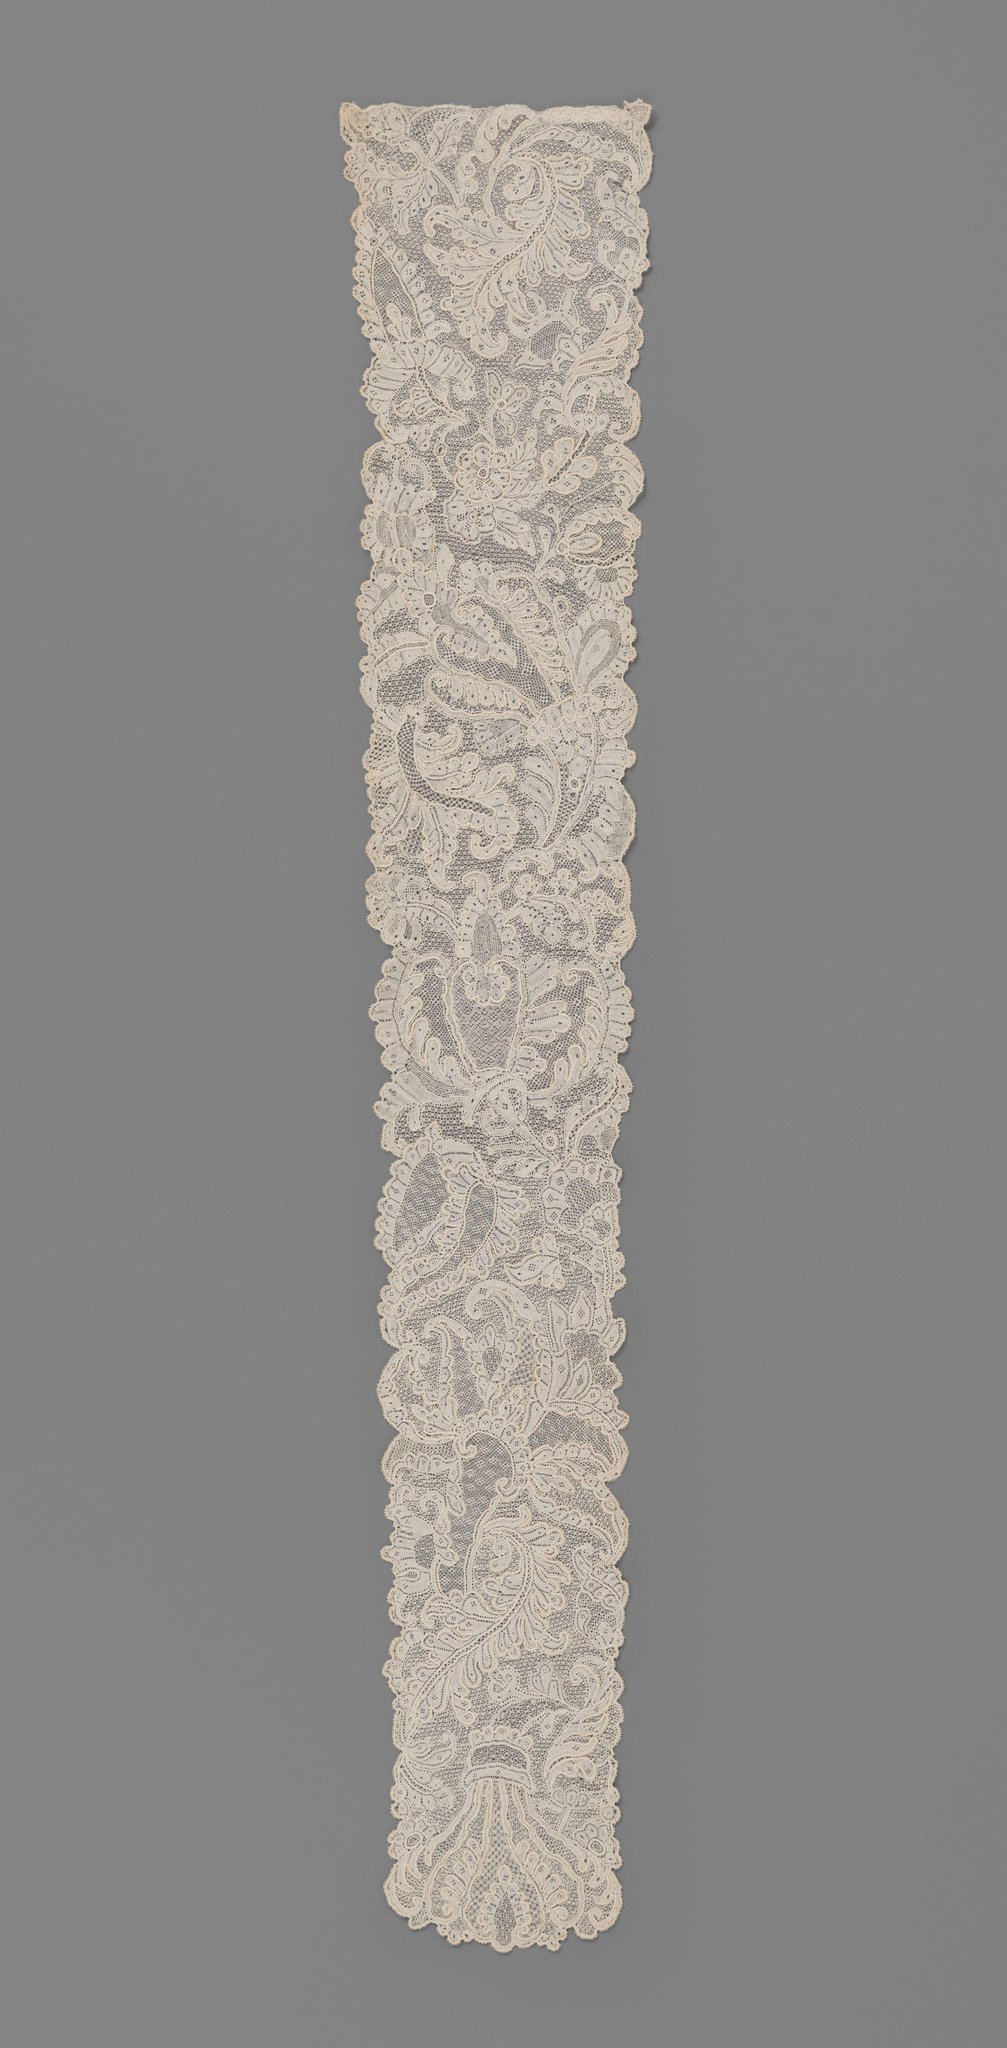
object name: lappet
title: Mutsenslip van naaldkant met acanthusbladeren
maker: Anonymous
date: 1720-1730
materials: linen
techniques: needle lace, régence lace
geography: france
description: Mutsenslip van naturelkleurige naaldkant, Régence-kant. Patroon met acanthusbladeren en weelderige bloemen, op een maasgrond versierd met vierkante moesjes. Volwerk met uitsparingen en veelsoortige siersteken. Reliëfcontouren met festonsteken.